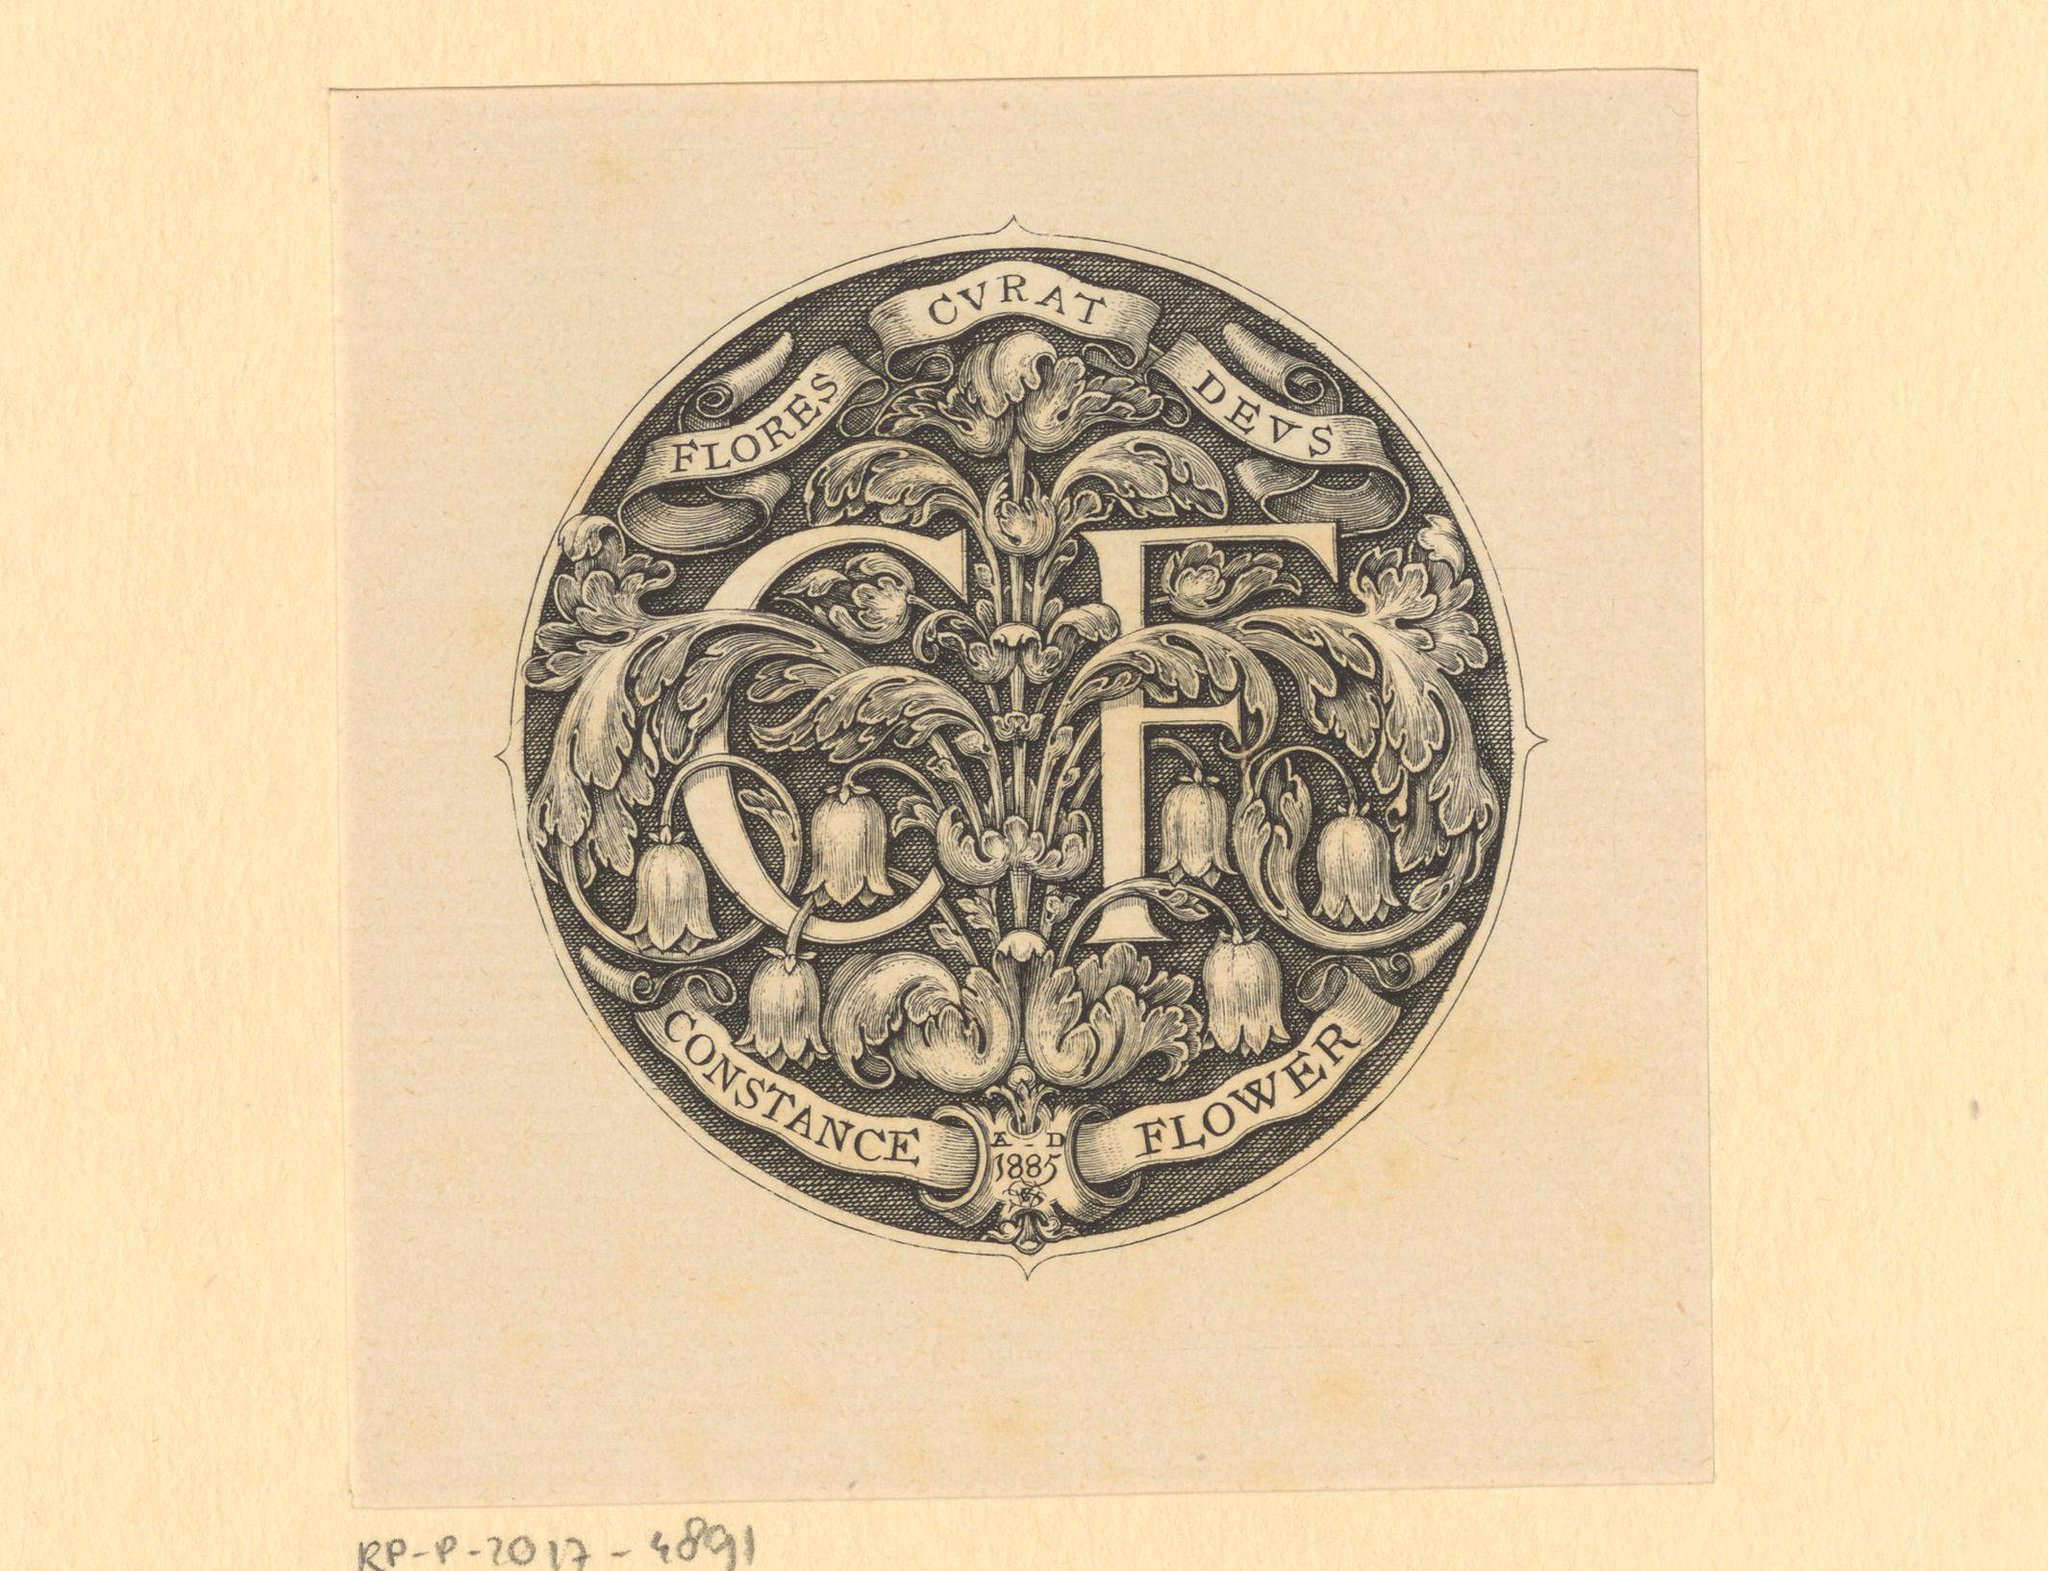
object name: bookplate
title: Ex libris van Constance Flower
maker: charles william sherborn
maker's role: print maker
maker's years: 1831-1912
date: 1885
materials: paper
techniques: engraving, etching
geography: england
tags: flowers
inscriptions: inscription: ‘C. Sherborn’